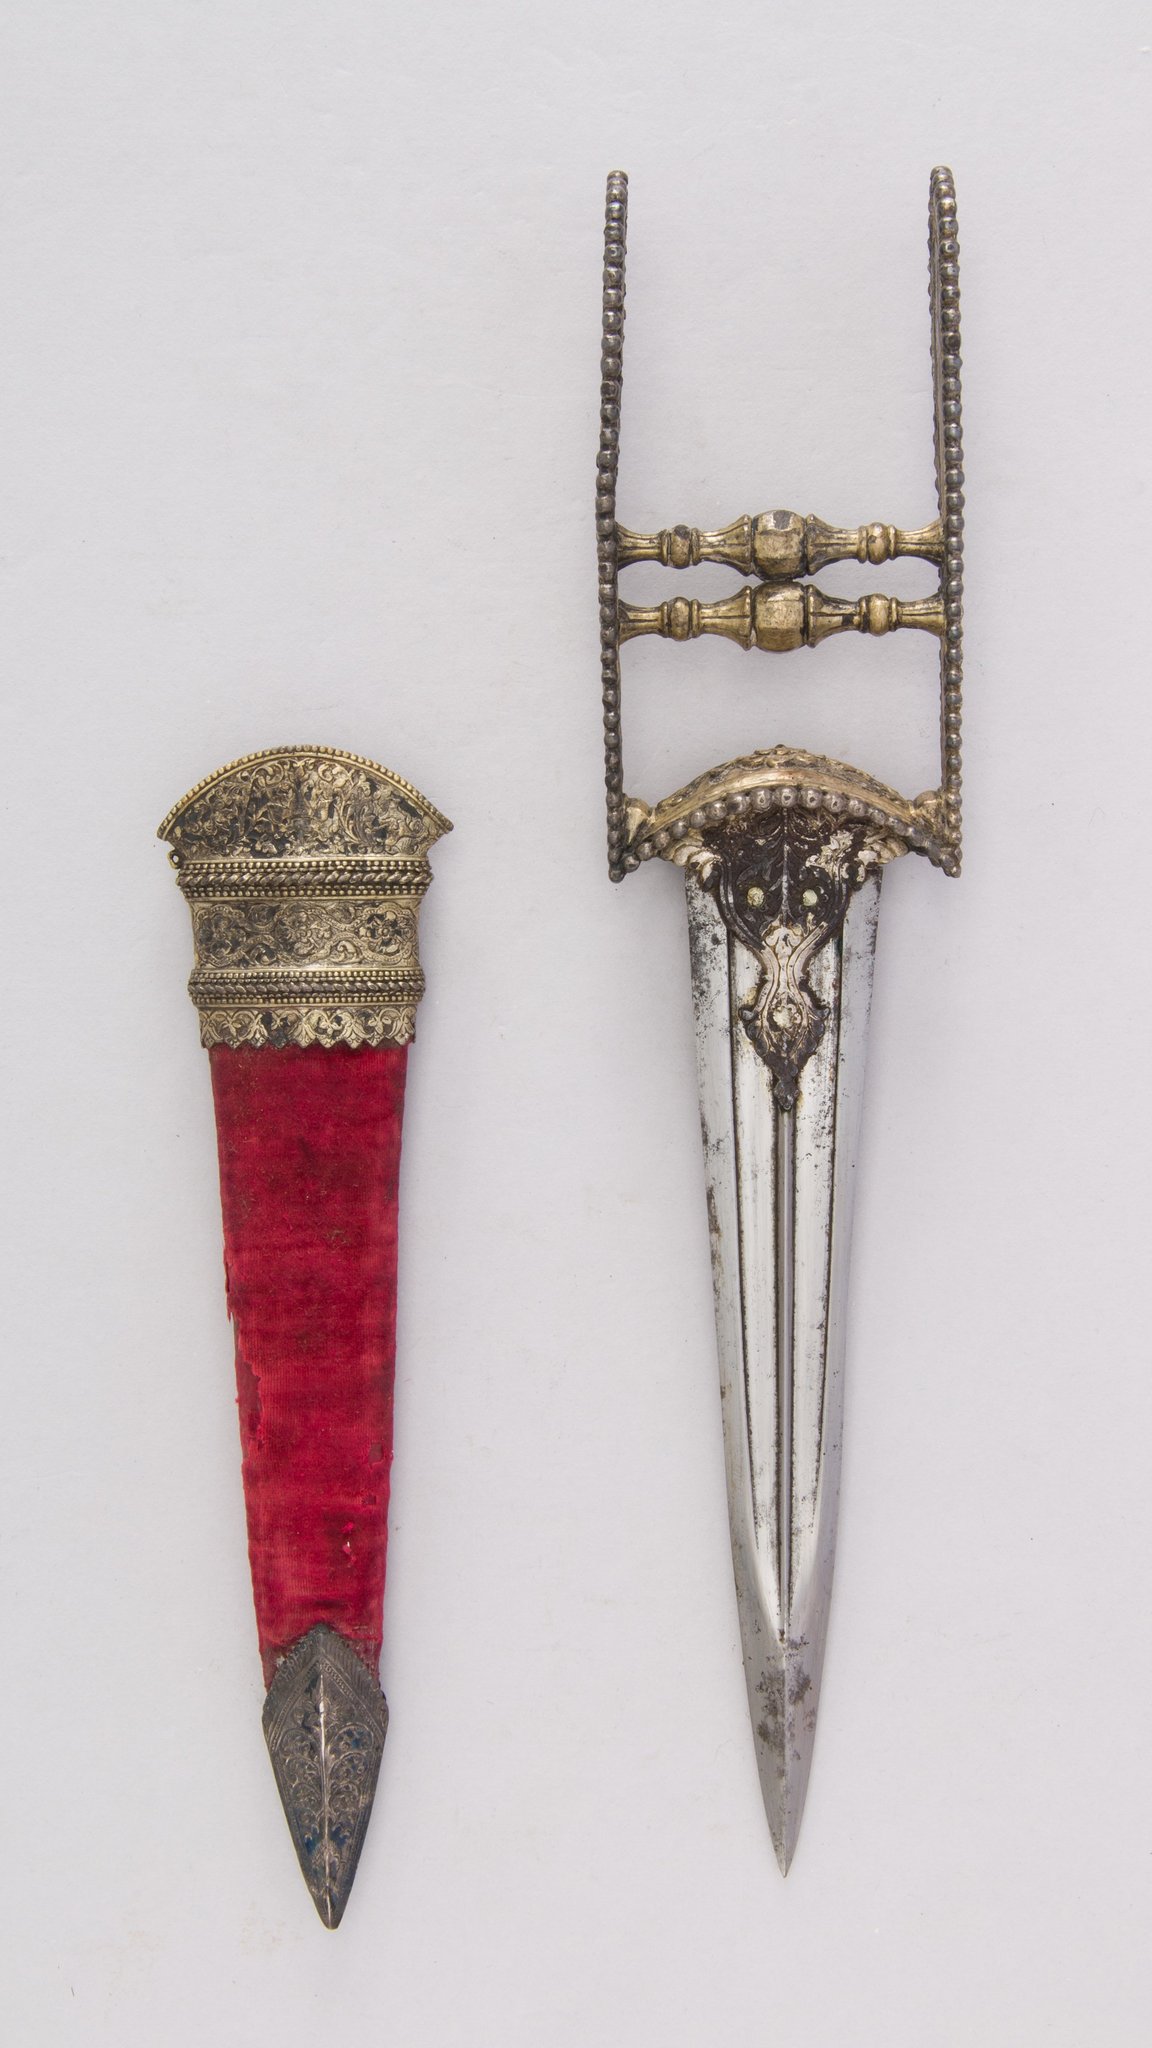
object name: dagger with sheath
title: Dagger (Katar) with Sheath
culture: indian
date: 1701-1800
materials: silver, steel, velvet, wood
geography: north india